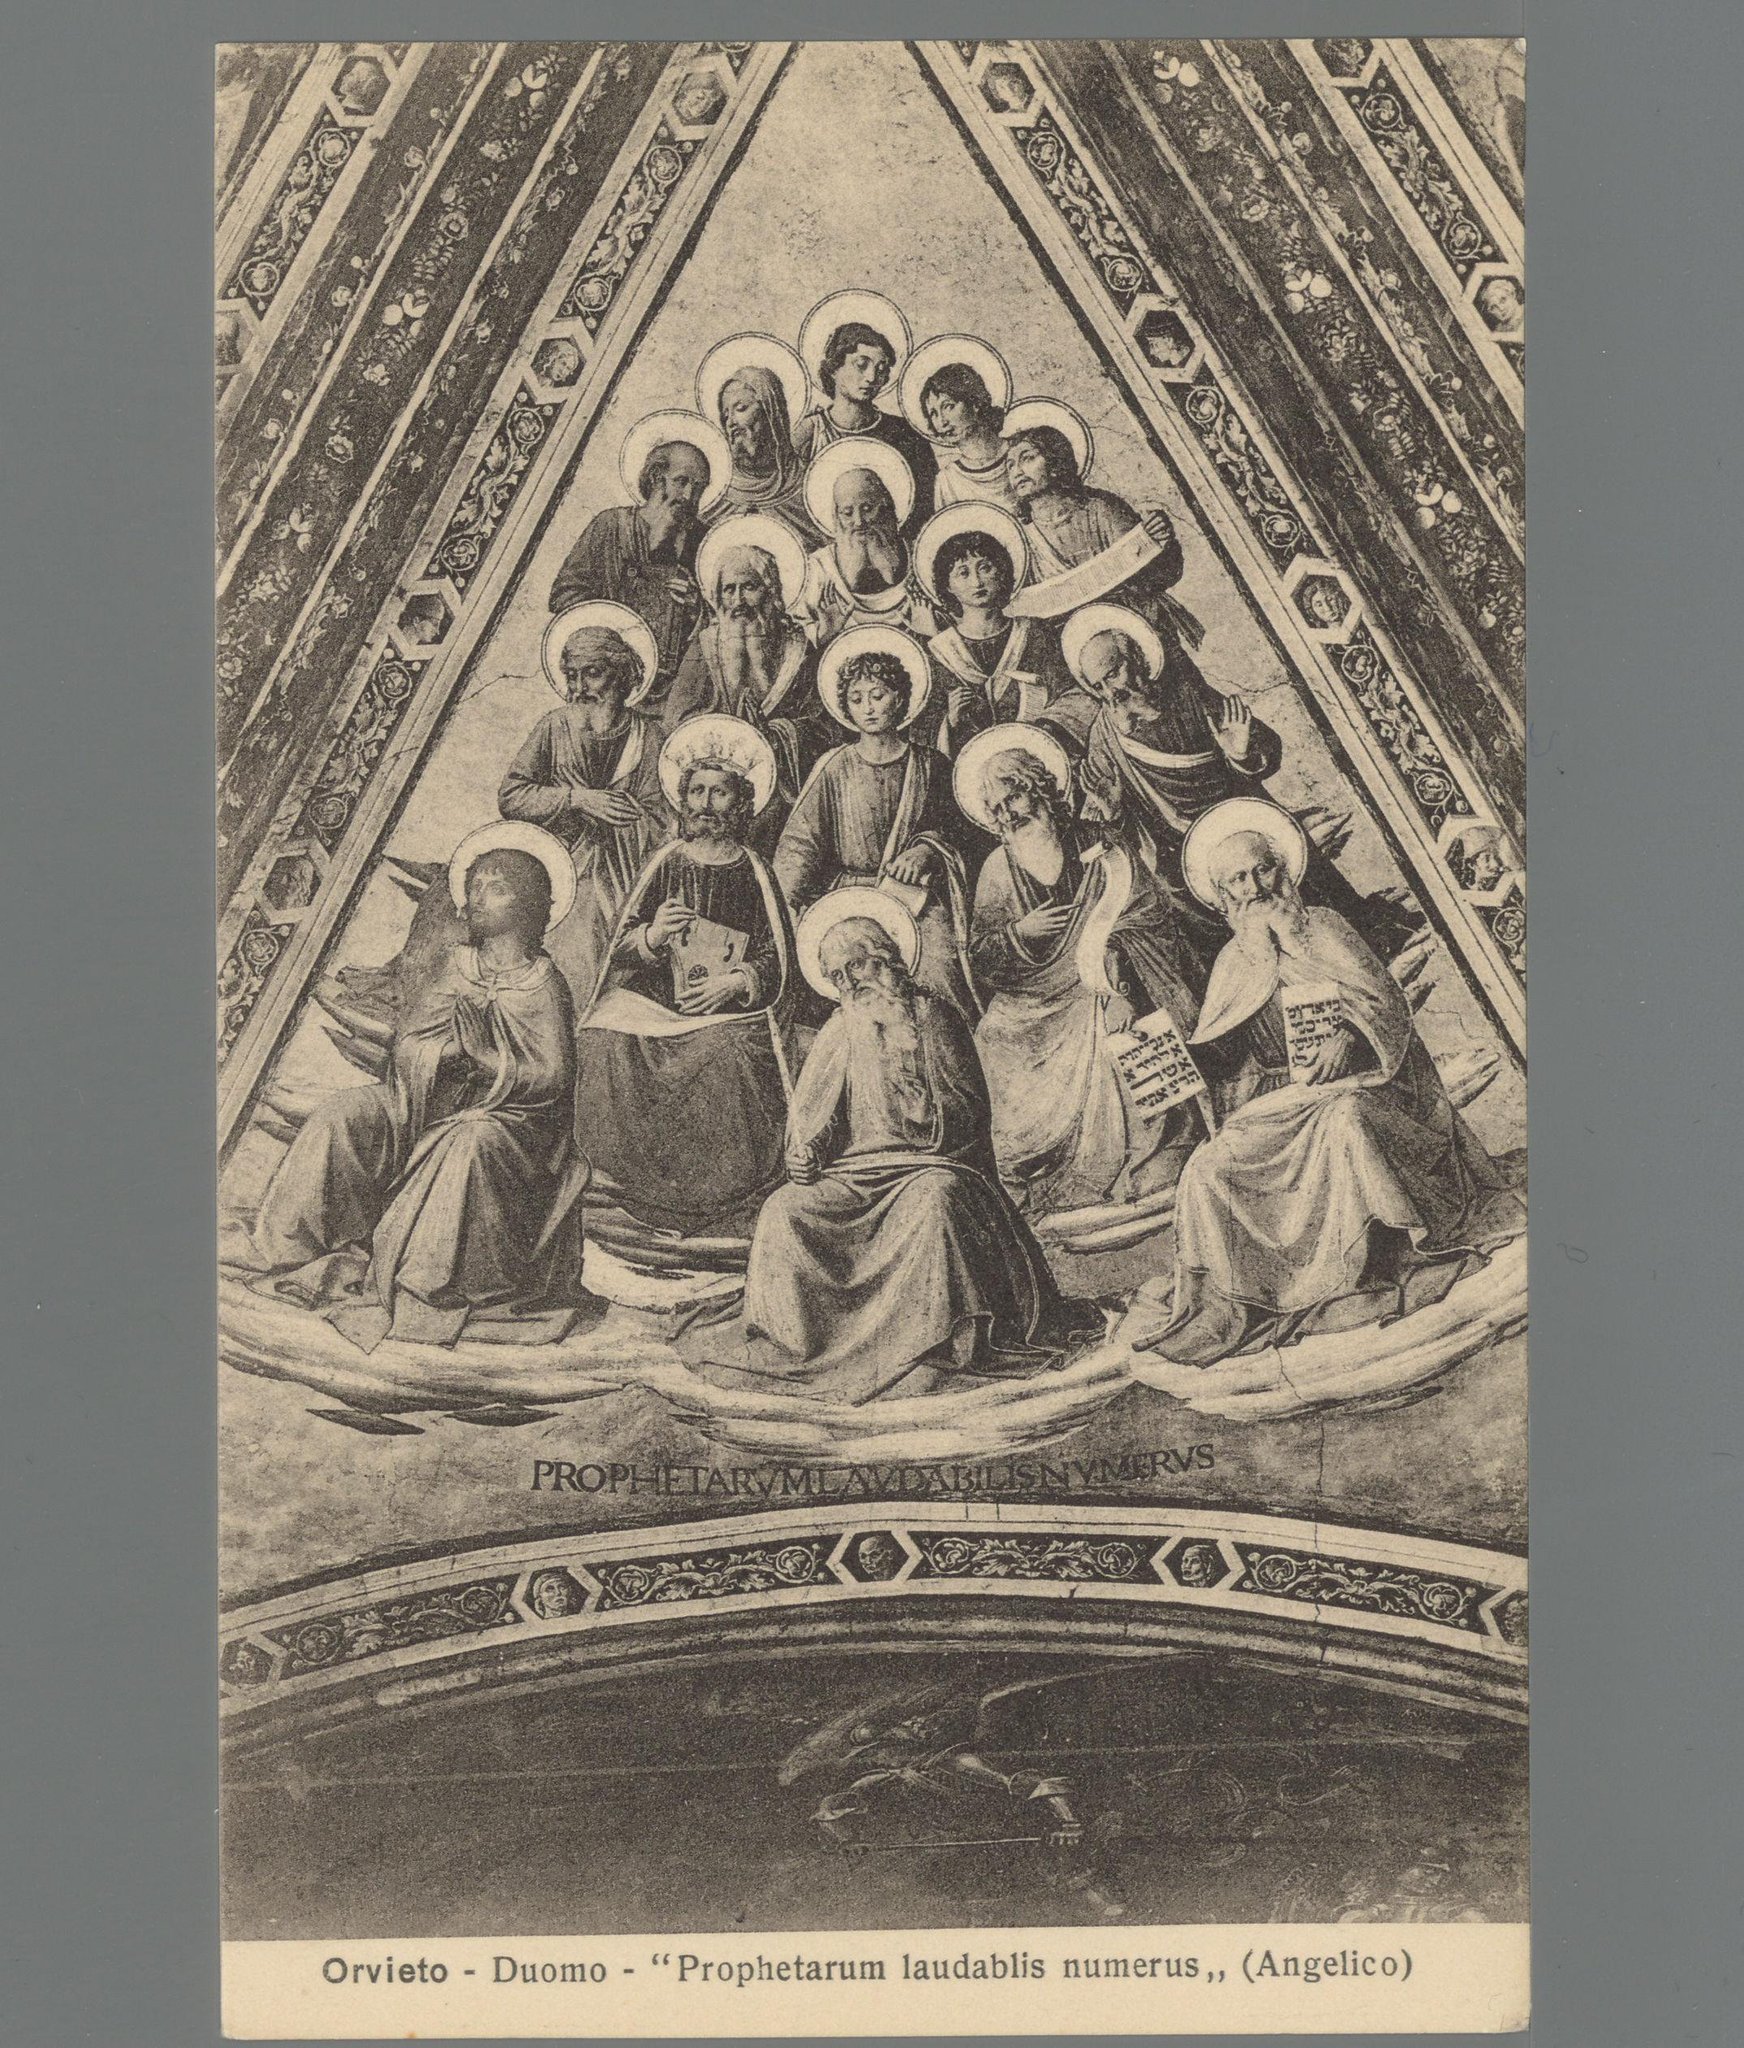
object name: photomechanical print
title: Orvieto. Duomo. "Prophetarum laudablis numerus" (Angelico)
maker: Anonymous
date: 1906-1910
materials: cardboard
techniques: photograph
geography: orvieto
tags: interior of church, picture, painting